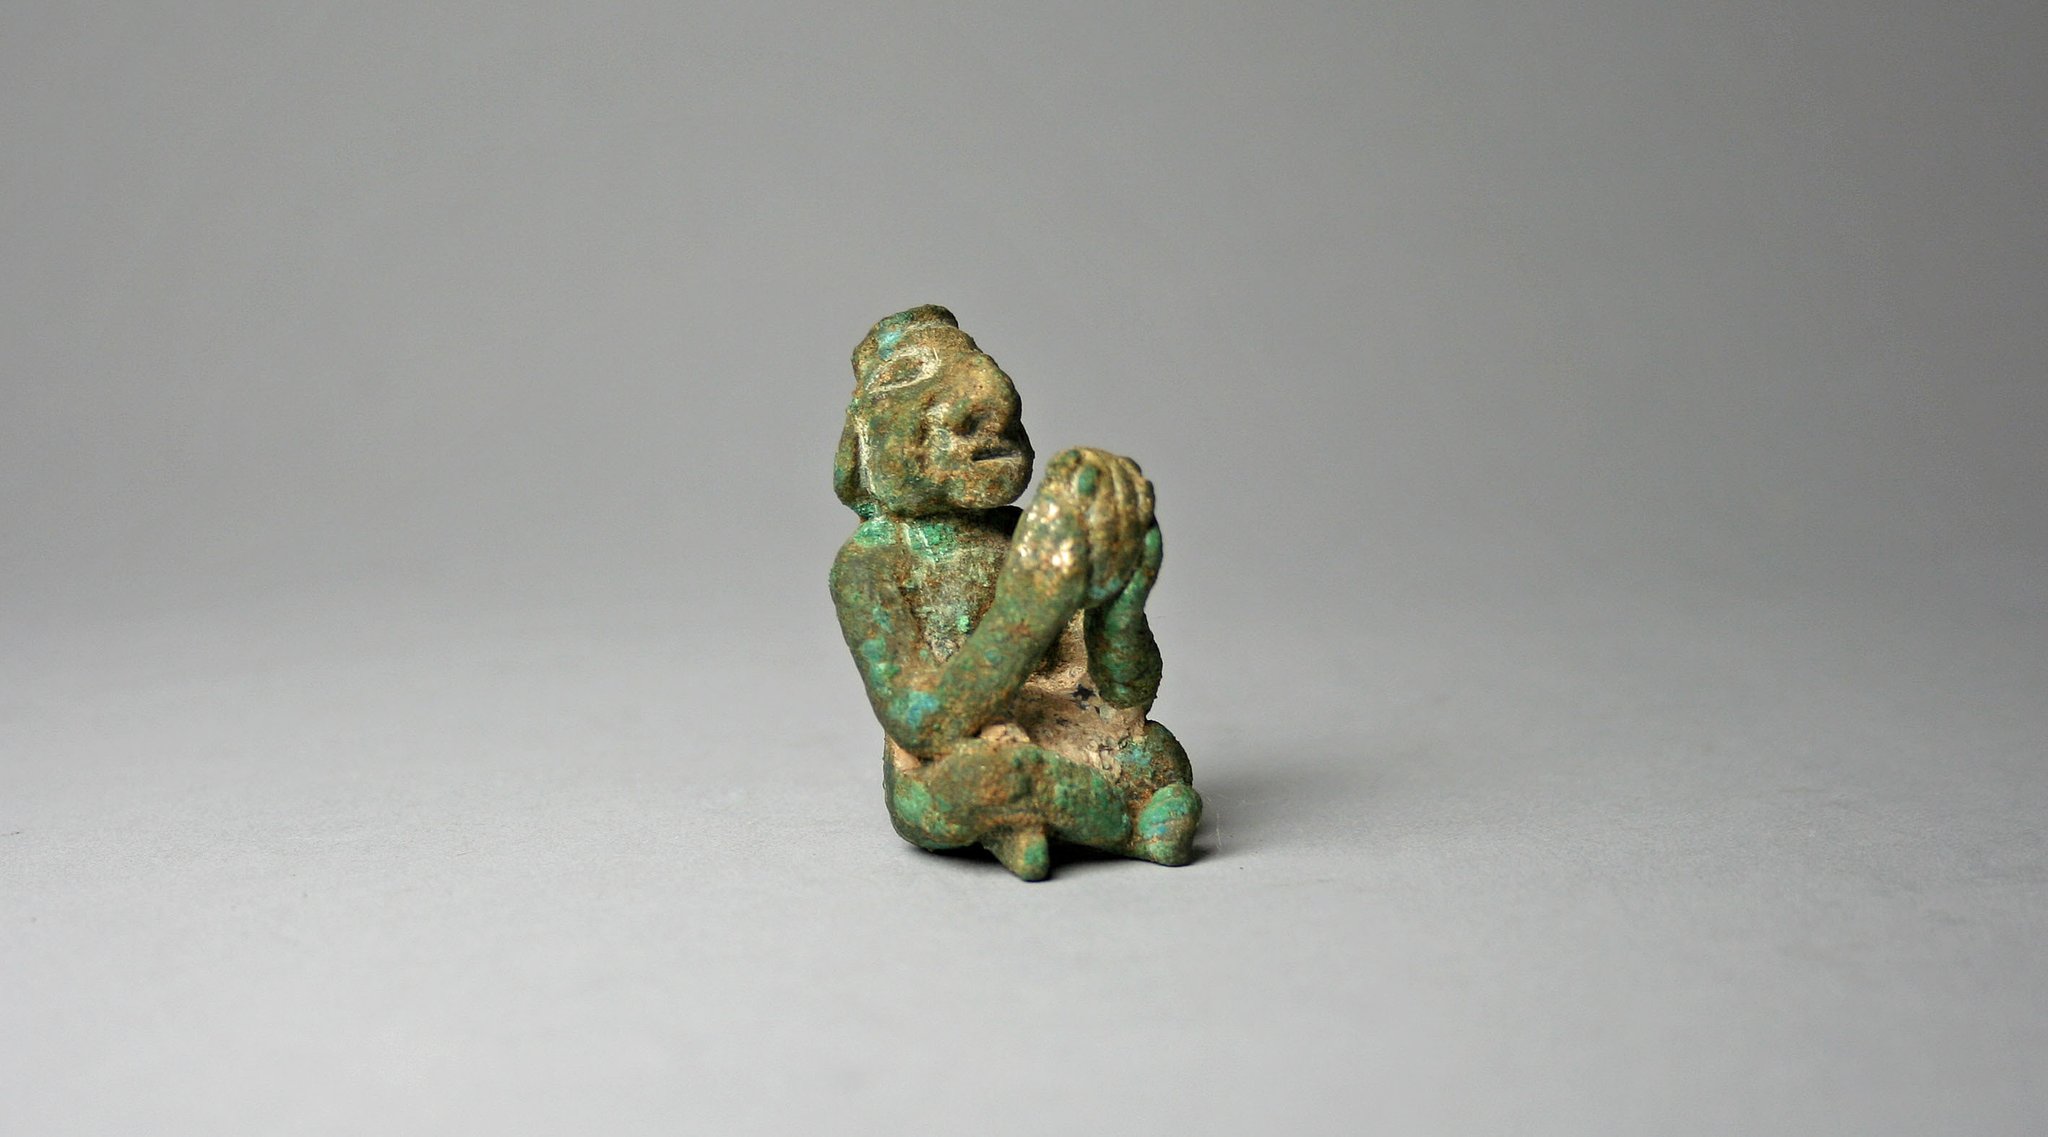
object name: ornament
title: Figure Ornament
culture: moche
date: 201-700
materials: copper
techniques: casting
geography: peru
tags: human figures